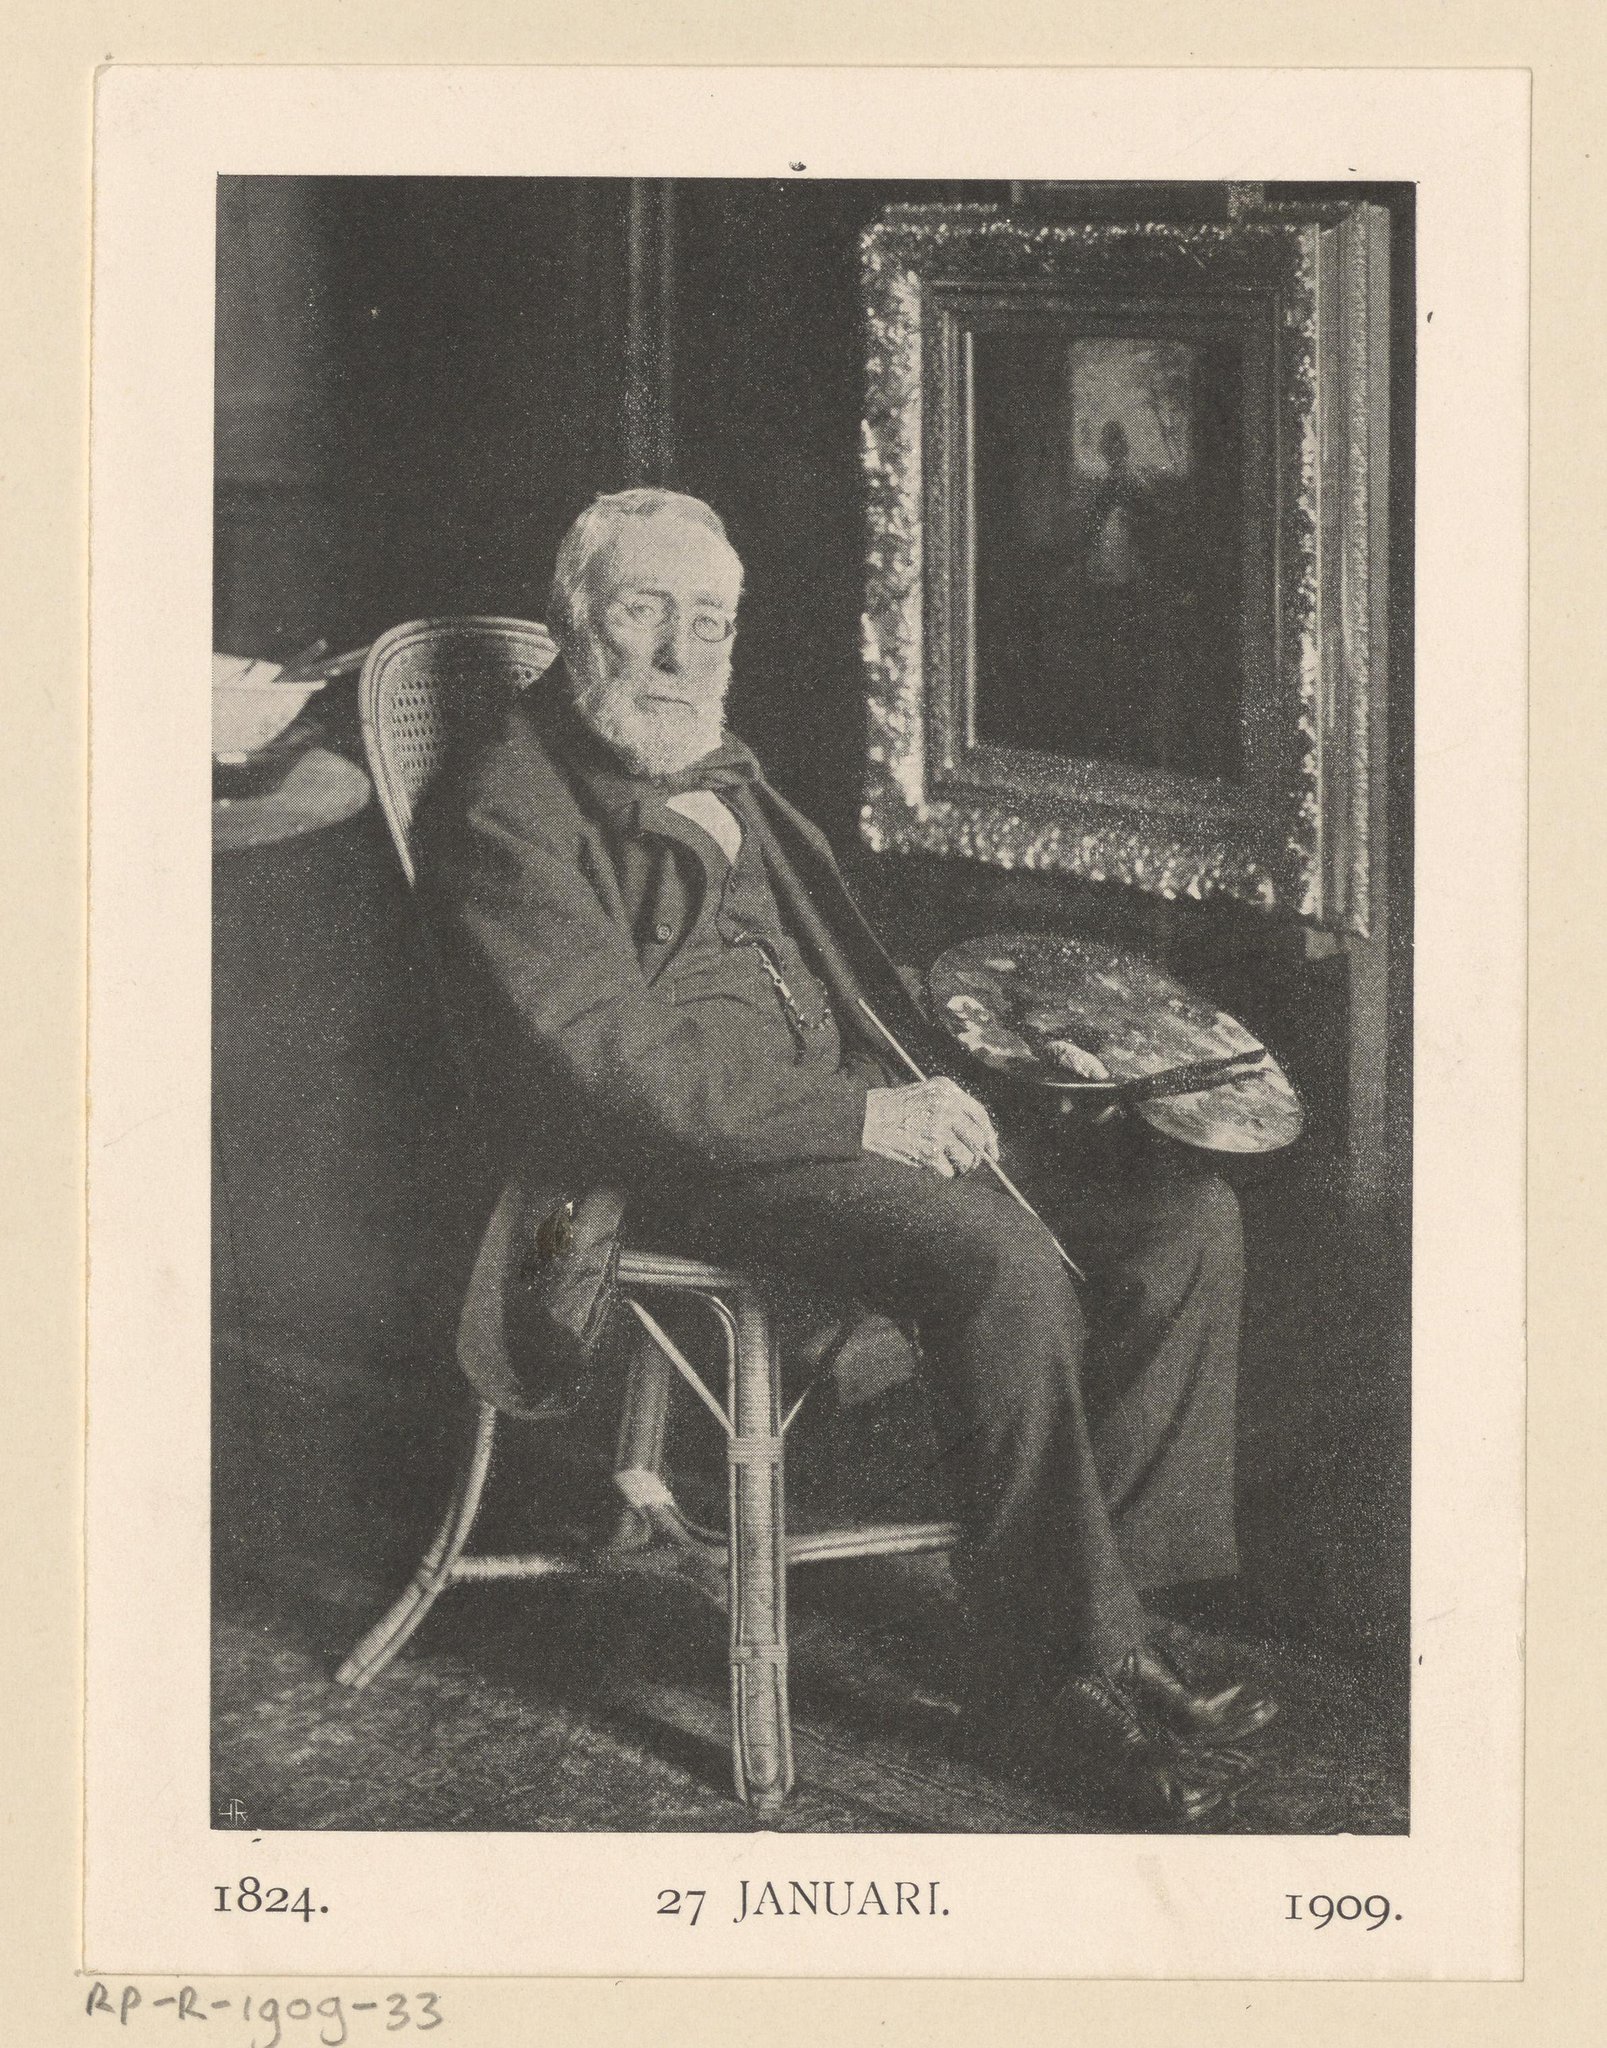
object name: photomechanical print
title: Portret van Jozef Israëls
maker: Anonymous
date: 1909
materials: paper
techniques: autotype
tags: print maker, draughtsman, jozef israëls, historical persons, portrait, self-portrait of painter, artist at work, in his workshop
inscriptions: monogram: ‘HR’, collector's mark: Lugt 2228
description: Zittend op een stoel met een palet en een penseel in zijn hand.